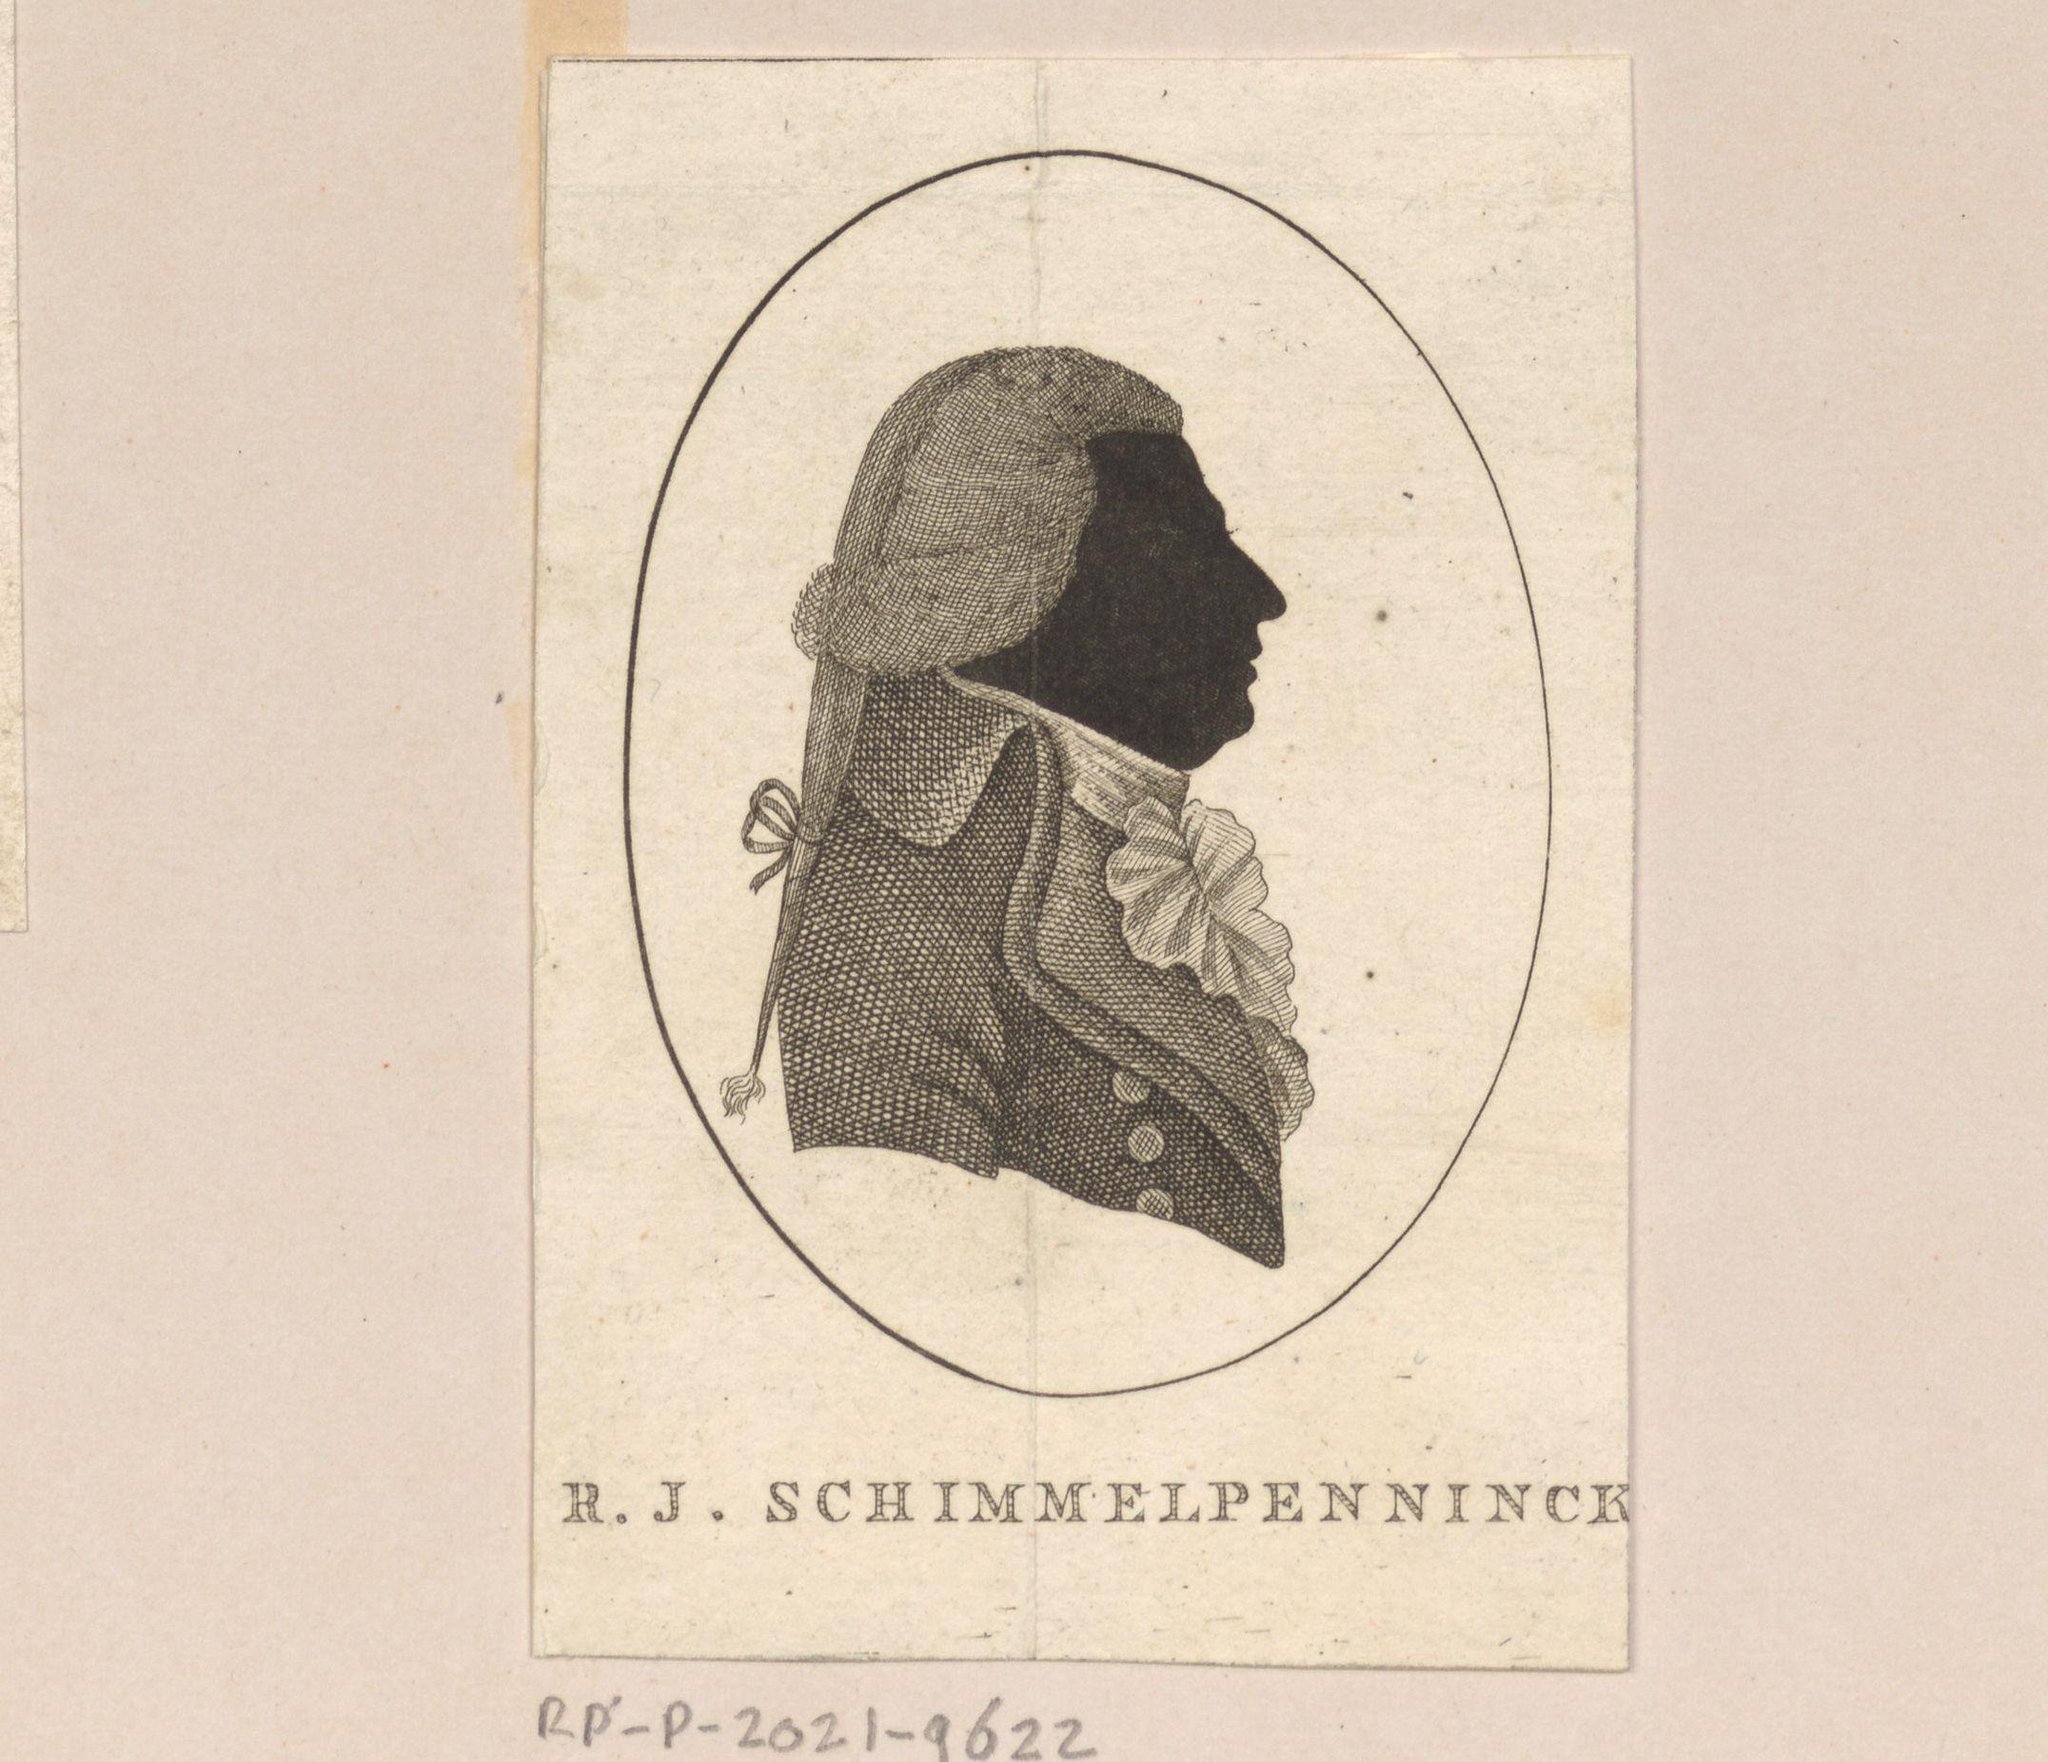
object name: print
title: Portret van Rutger Jan Schimmelpenninck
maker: Anonymous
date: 1799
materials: paper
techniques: etching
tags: deventer, amsterdam, rutger jan schimmelpenninck (1761-1825), historical persons, politician, e.g. party leader, diplomacy, diplomat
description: Prent maakt deel uit van een grotere prent met portretten die later is verknipt. Prent waarschijnlijk uit: Rogge, Cornelis. Geschiedenis der staatsregeling, voor het Bataafsche volk. Amsterdam: Johannes Allart, 1799.